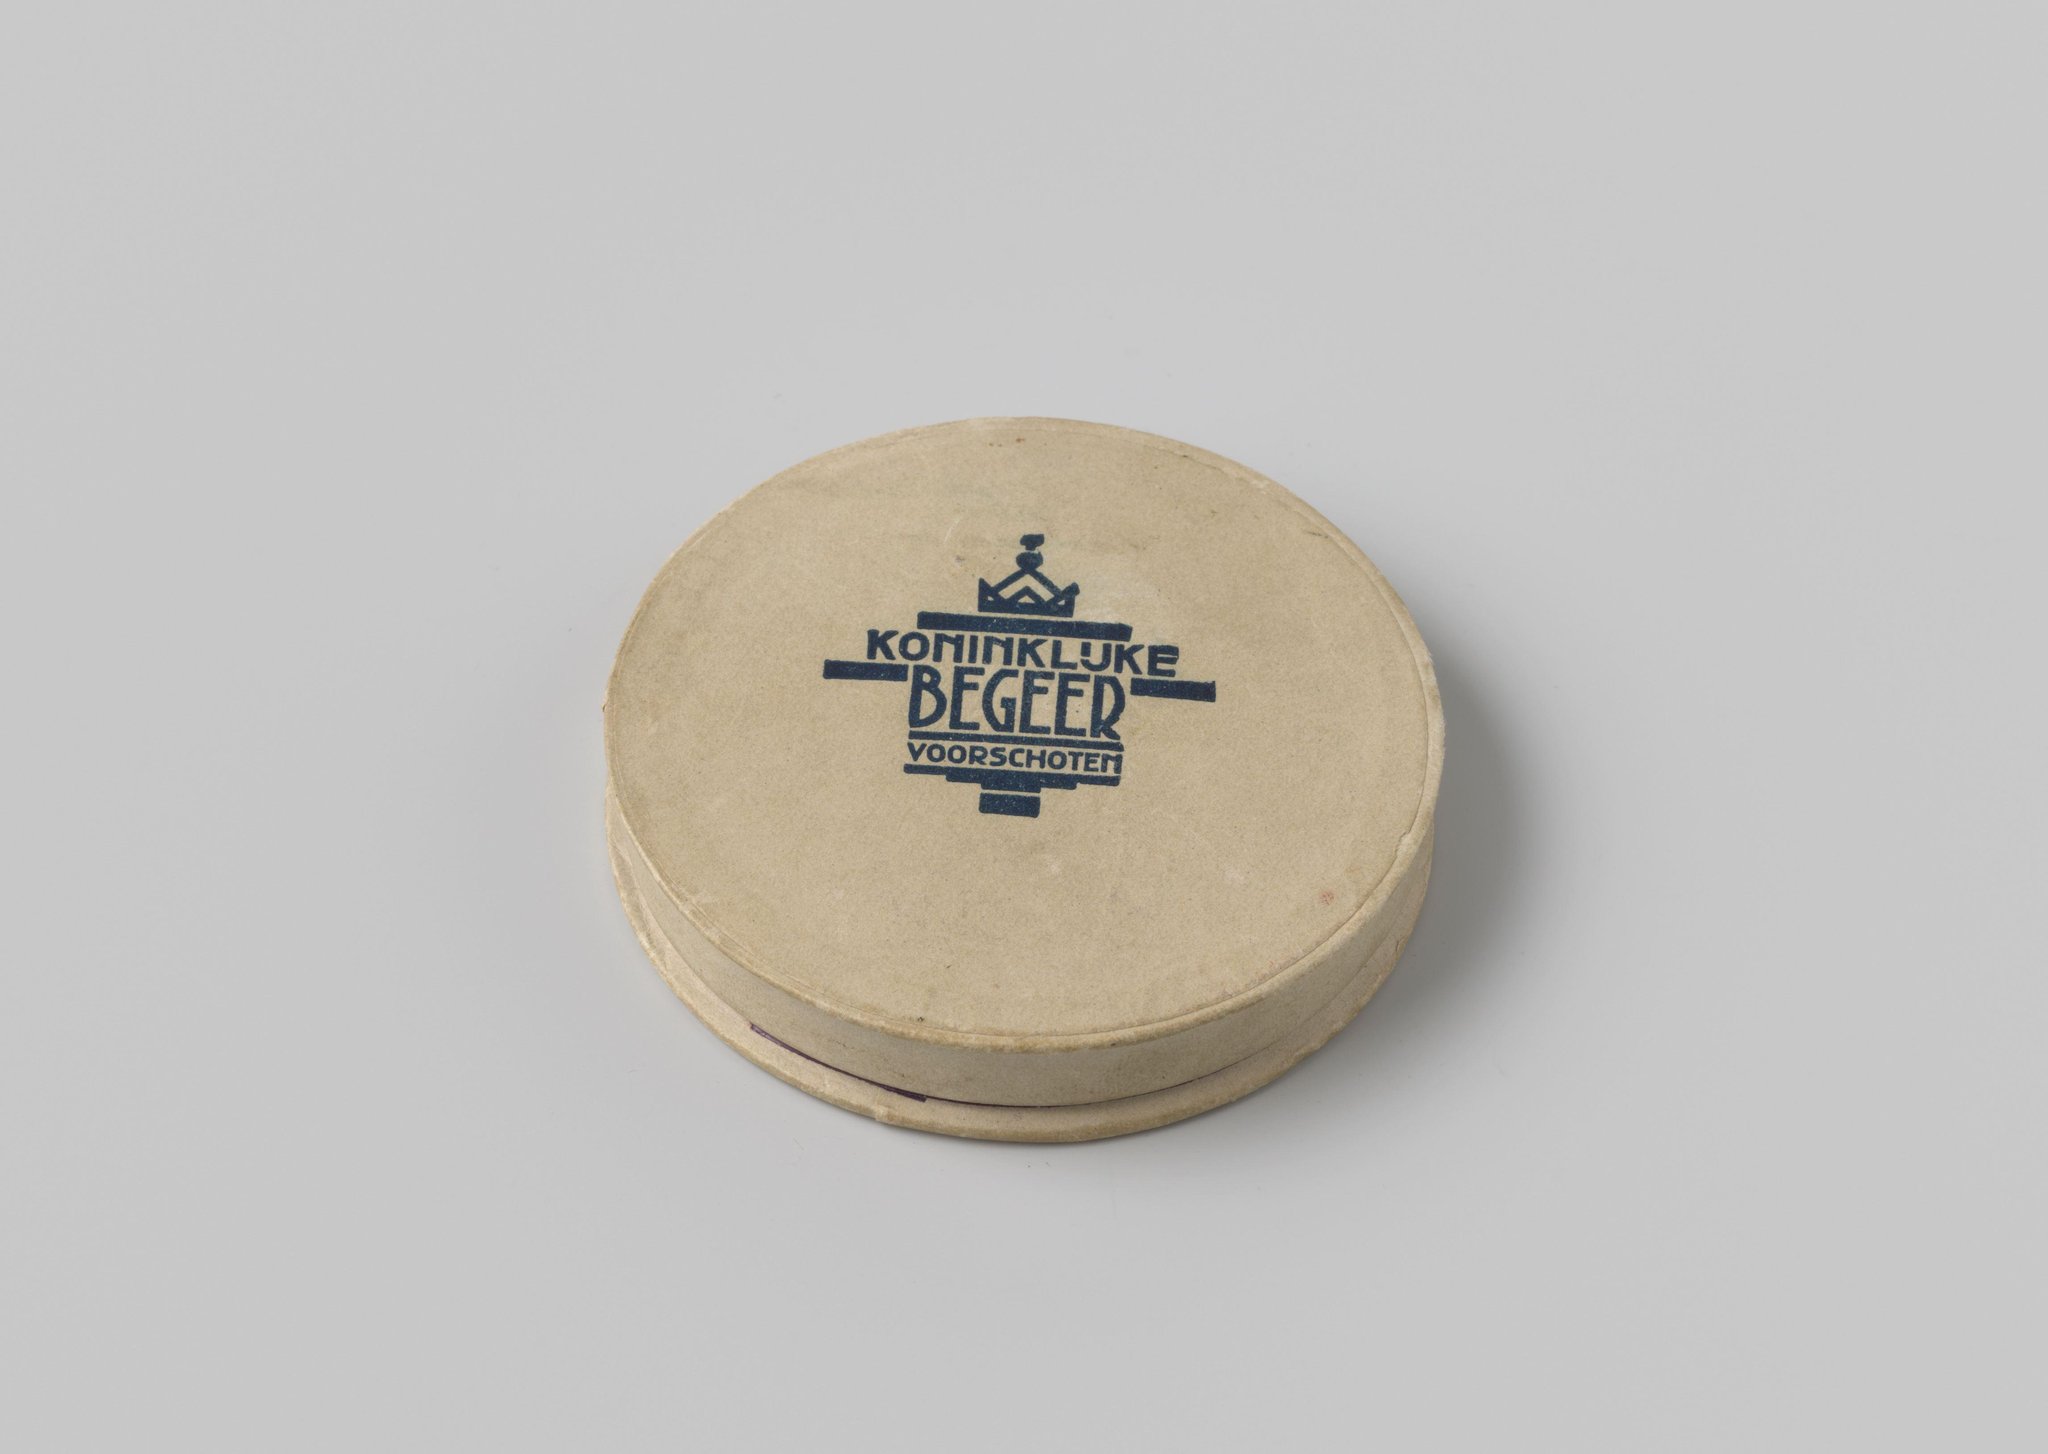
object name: box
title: Doosje bij penning 250ste sterfjaar Michiel Adriaenszoon de Ruyter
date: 1926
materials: cardboard, paper, velvet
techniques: printing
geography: voorschoten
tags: flushing, michiel adriaenszoon de ruyter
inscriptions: mark: ‘KONINKLIJKE BEGEER VOORSCHOTEN’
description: Wit rond kartonnen doosje, binnenzijde met paars fluweel bekleed. Deksel v.z.v. opdruk.